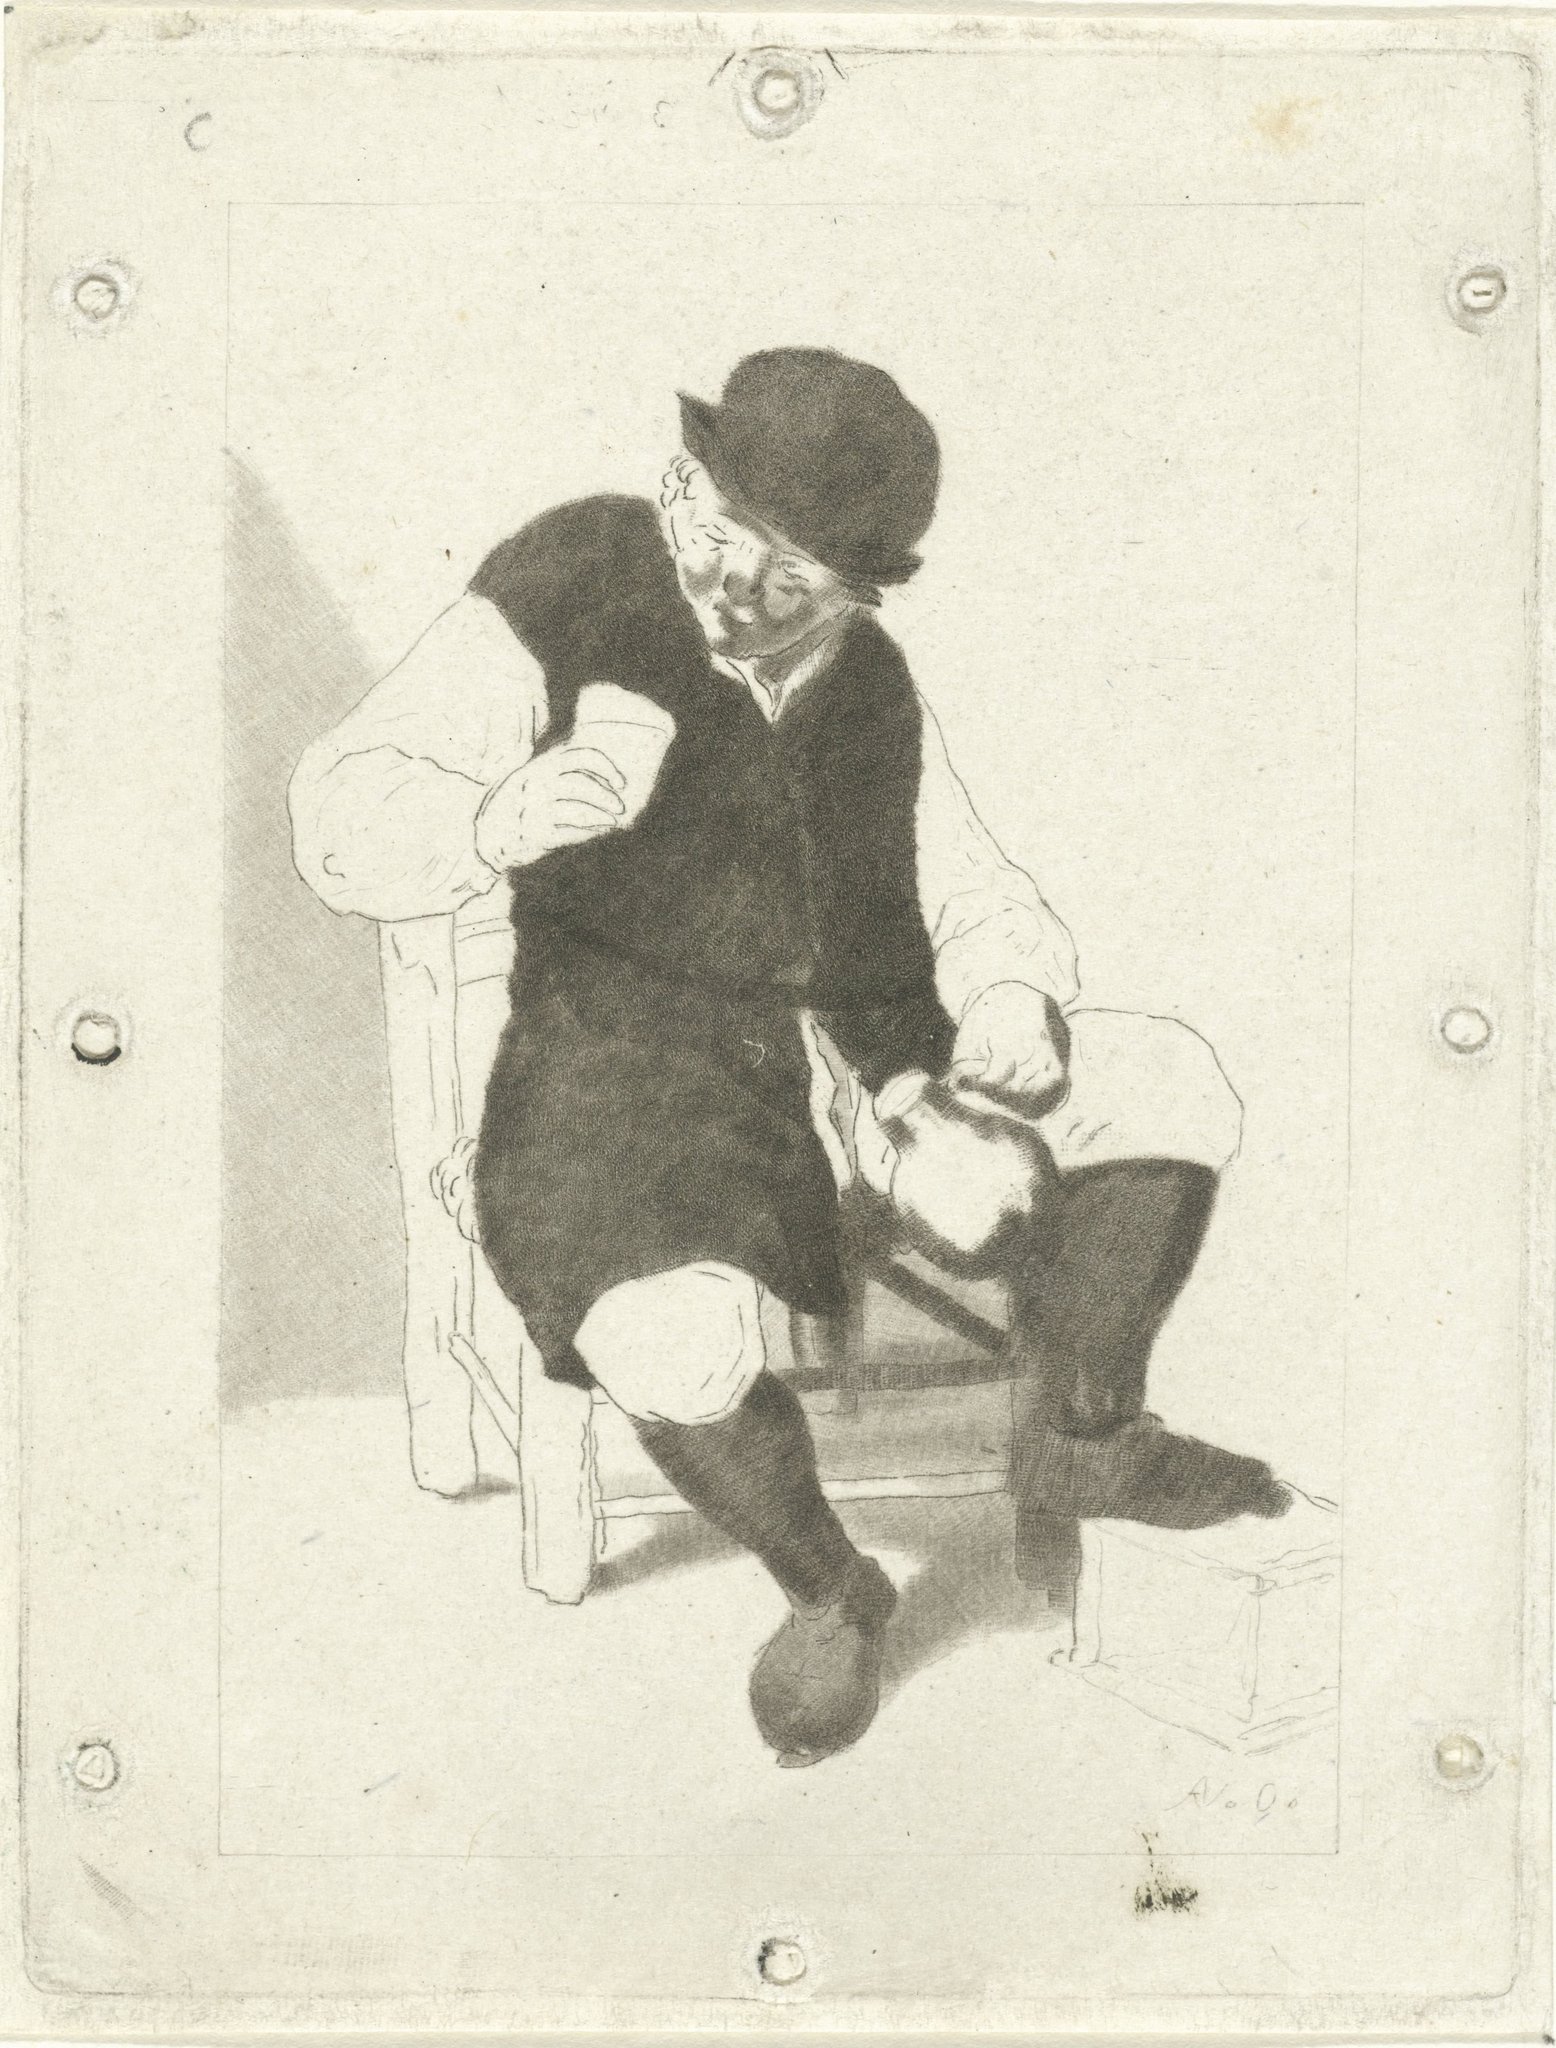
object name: print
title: Zittende boer met kruik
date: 1763-1768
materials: paper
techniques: etching, roulette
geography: amsterdam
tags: sitting figure, jar, jug (used as drinking-vessel)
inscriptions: collector's mark: Lugt 2228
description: Voor deze prenttekening, 'Zittende boer met kruik', maakte Ploos van Amstel vier verschillende platen (A, B, C, en D). Er bestaan afdrukken van één, twee, drie of alle vier de platen in alle mogelijke combinaties. Zie gerelateerde objecten voor de hier gebruikte plaat.